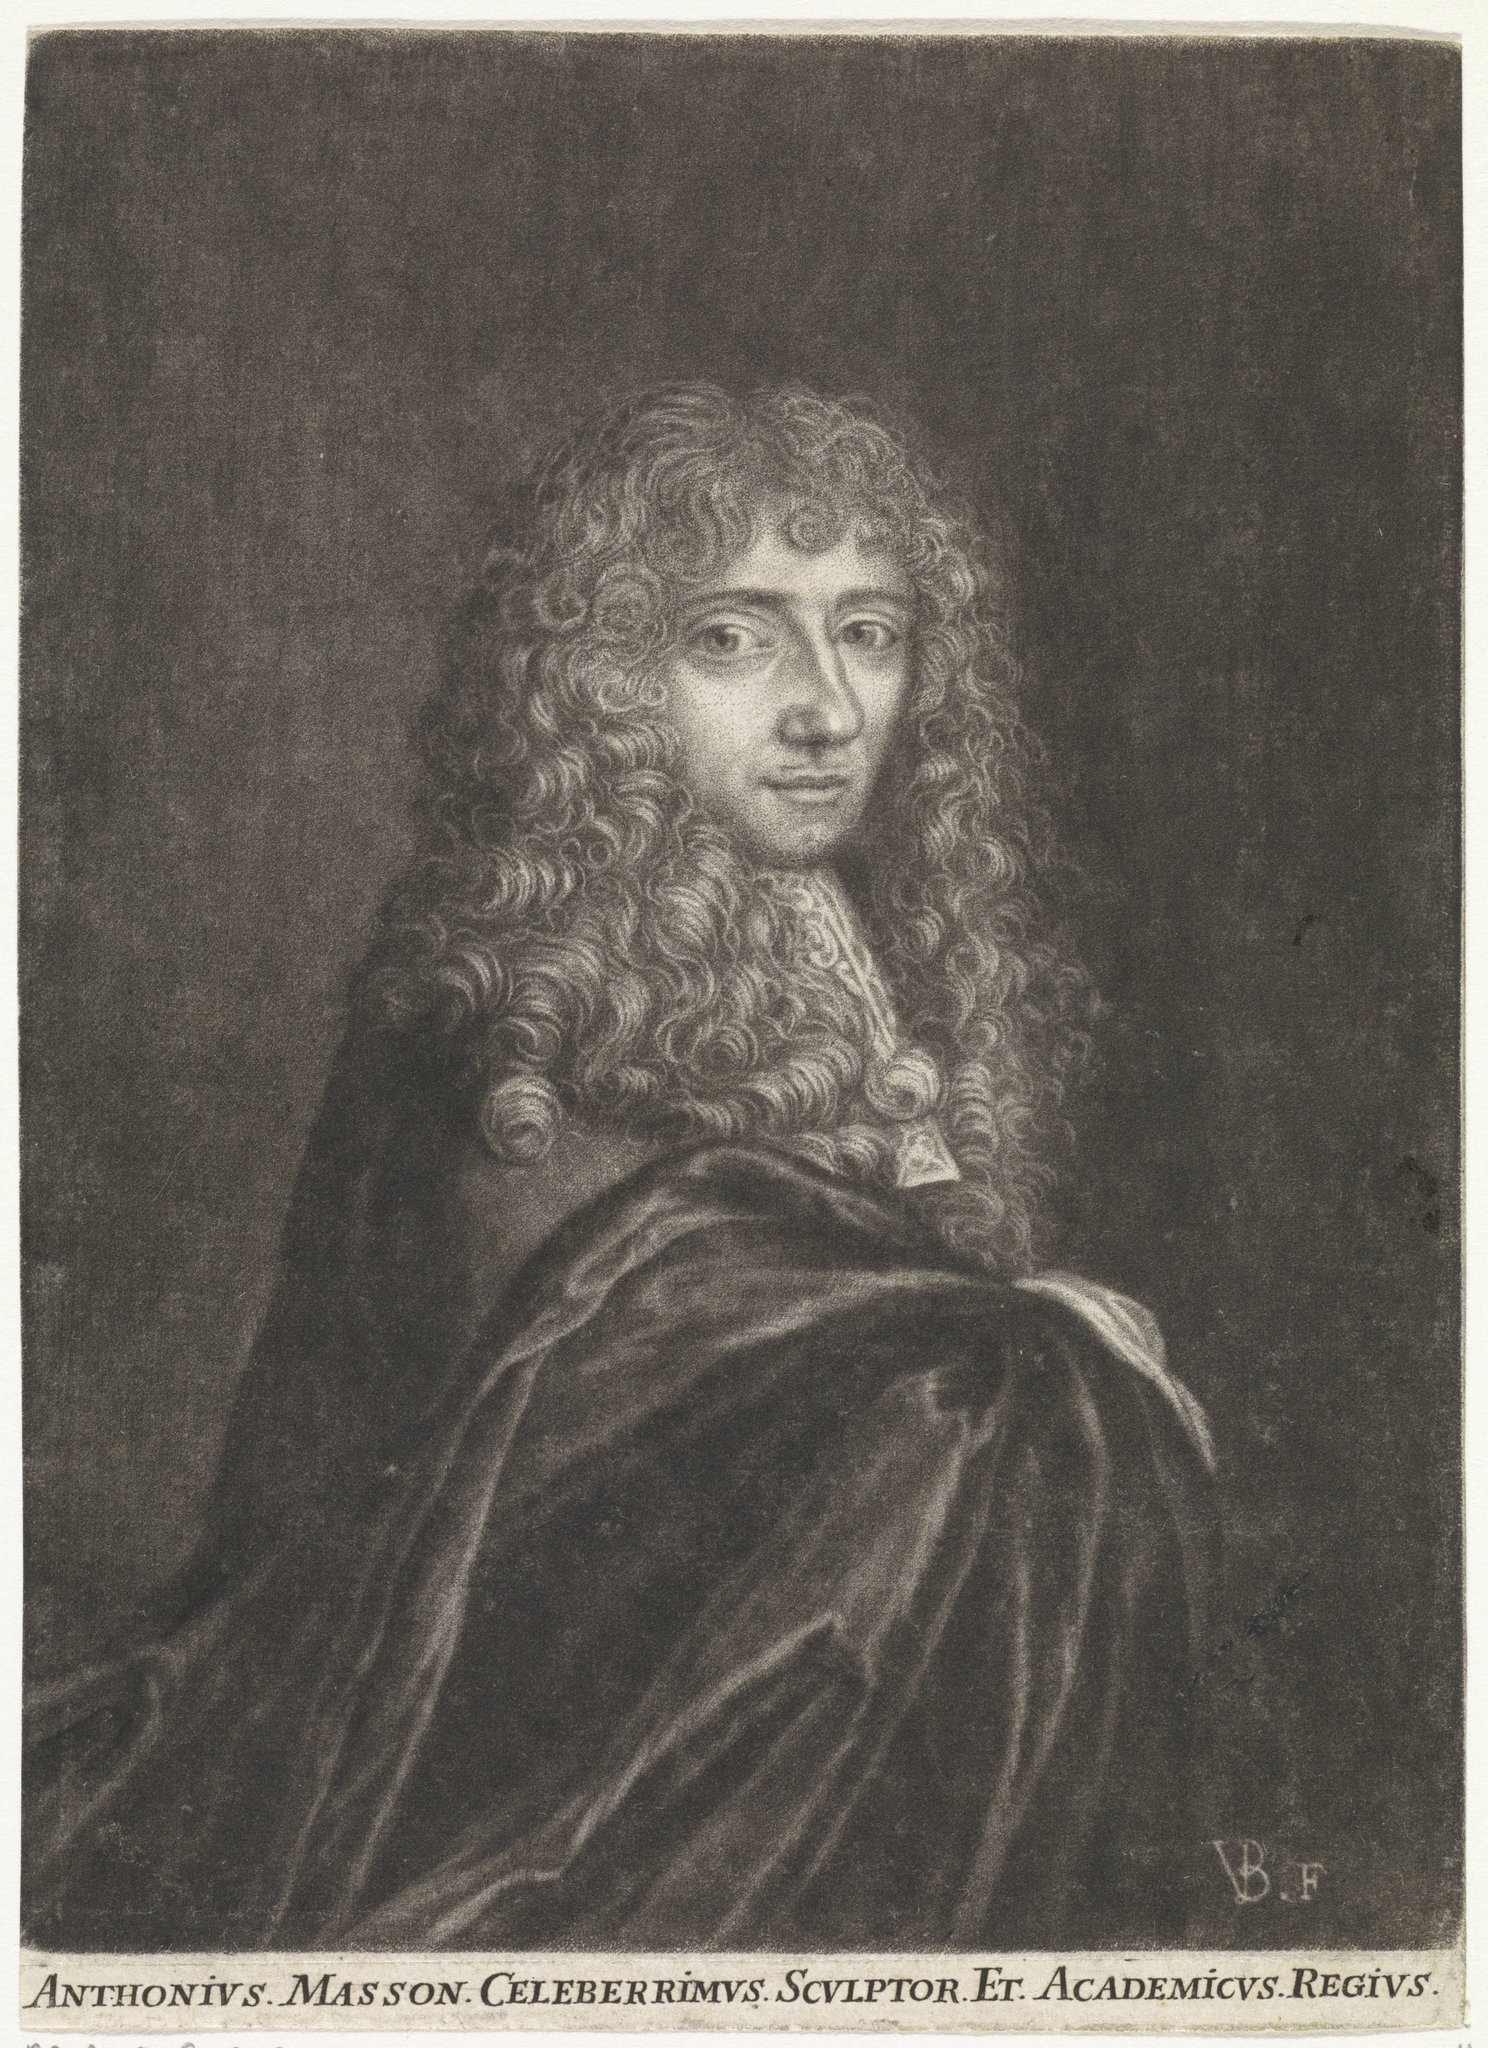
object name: print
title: Portret van Antoine Masson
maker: jan van der bruggen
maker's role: draughtsman, print maker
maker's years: 1649-1709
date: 1659-1740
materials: paper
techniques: engraving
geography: paris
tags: paris, antoine masson, wig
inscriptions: collector's mark: Lugt 2228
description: Portret van de Franse graveur Antoine Masson met een lange krulpruik.